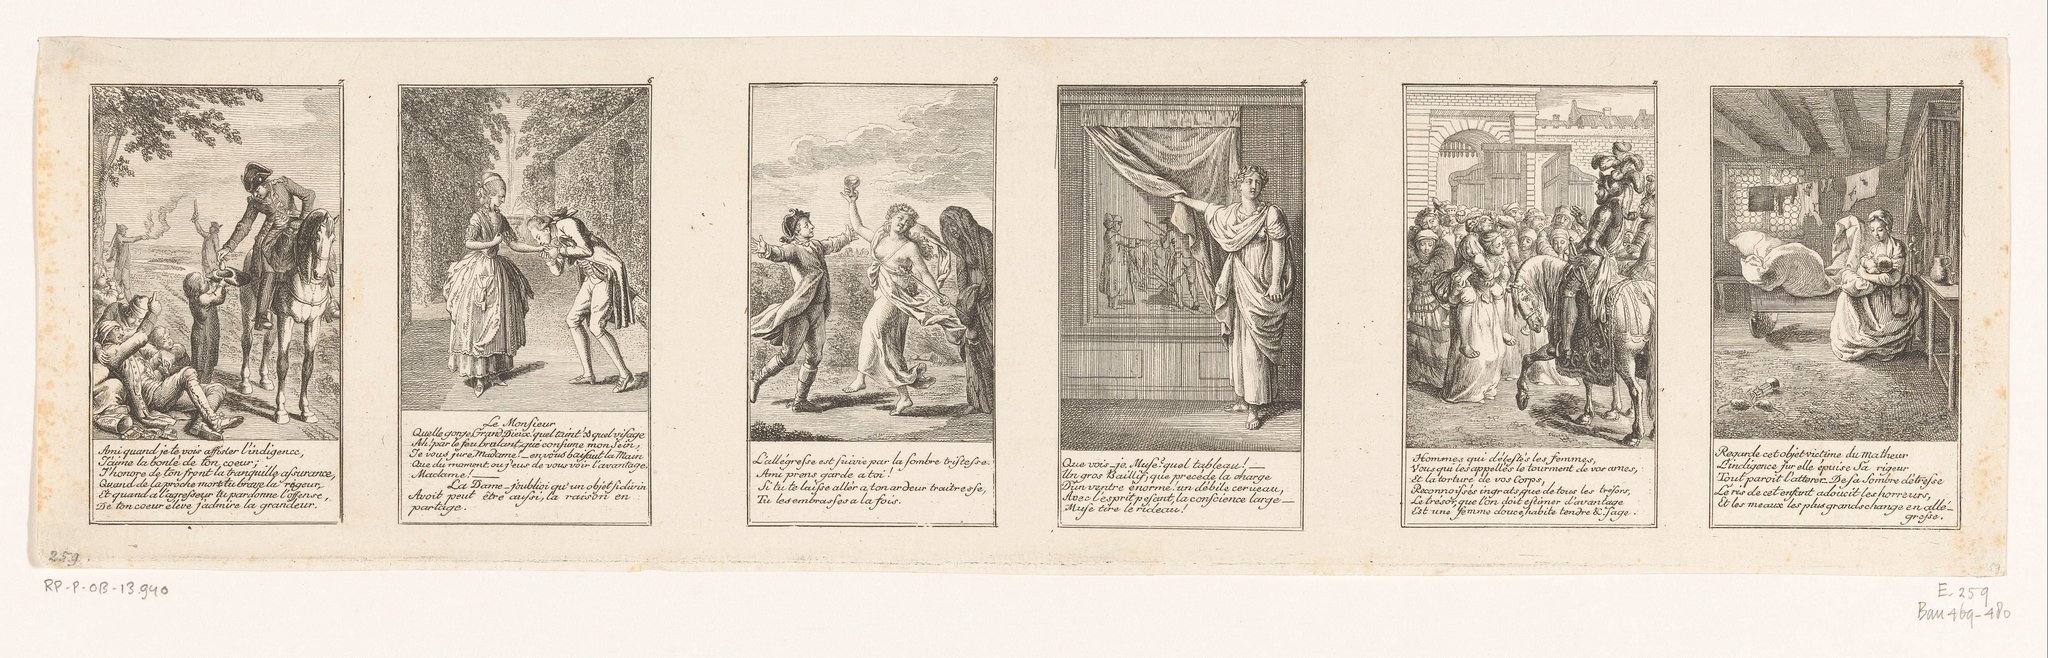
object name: print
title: Zes moralistische en satirische voorstellingen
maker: daniel nikolaus chodowiecki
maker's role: draughtsman, print maker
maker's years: 1726-1801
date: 1778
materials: paper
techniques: etching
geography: berlin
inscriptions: collector's mark: Lugt 2228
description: Zes prenten uit een serie van twaalf moralistische en satirische voorstellingen. De scènes werden op een plaat geëtst. Deze serie is ook gebruikt in: Almanac genéalogique pour l'an 1779. Lauenburg: J.G. Berenberg. Deze serie is een herhaling van de serie met Duitse onderschriften die werd gebruikt voor de Duitse versie van deze almanak (zie: RP-P-OB-13.938). Later herhaalde Chodowiecki de serie nogmaals.